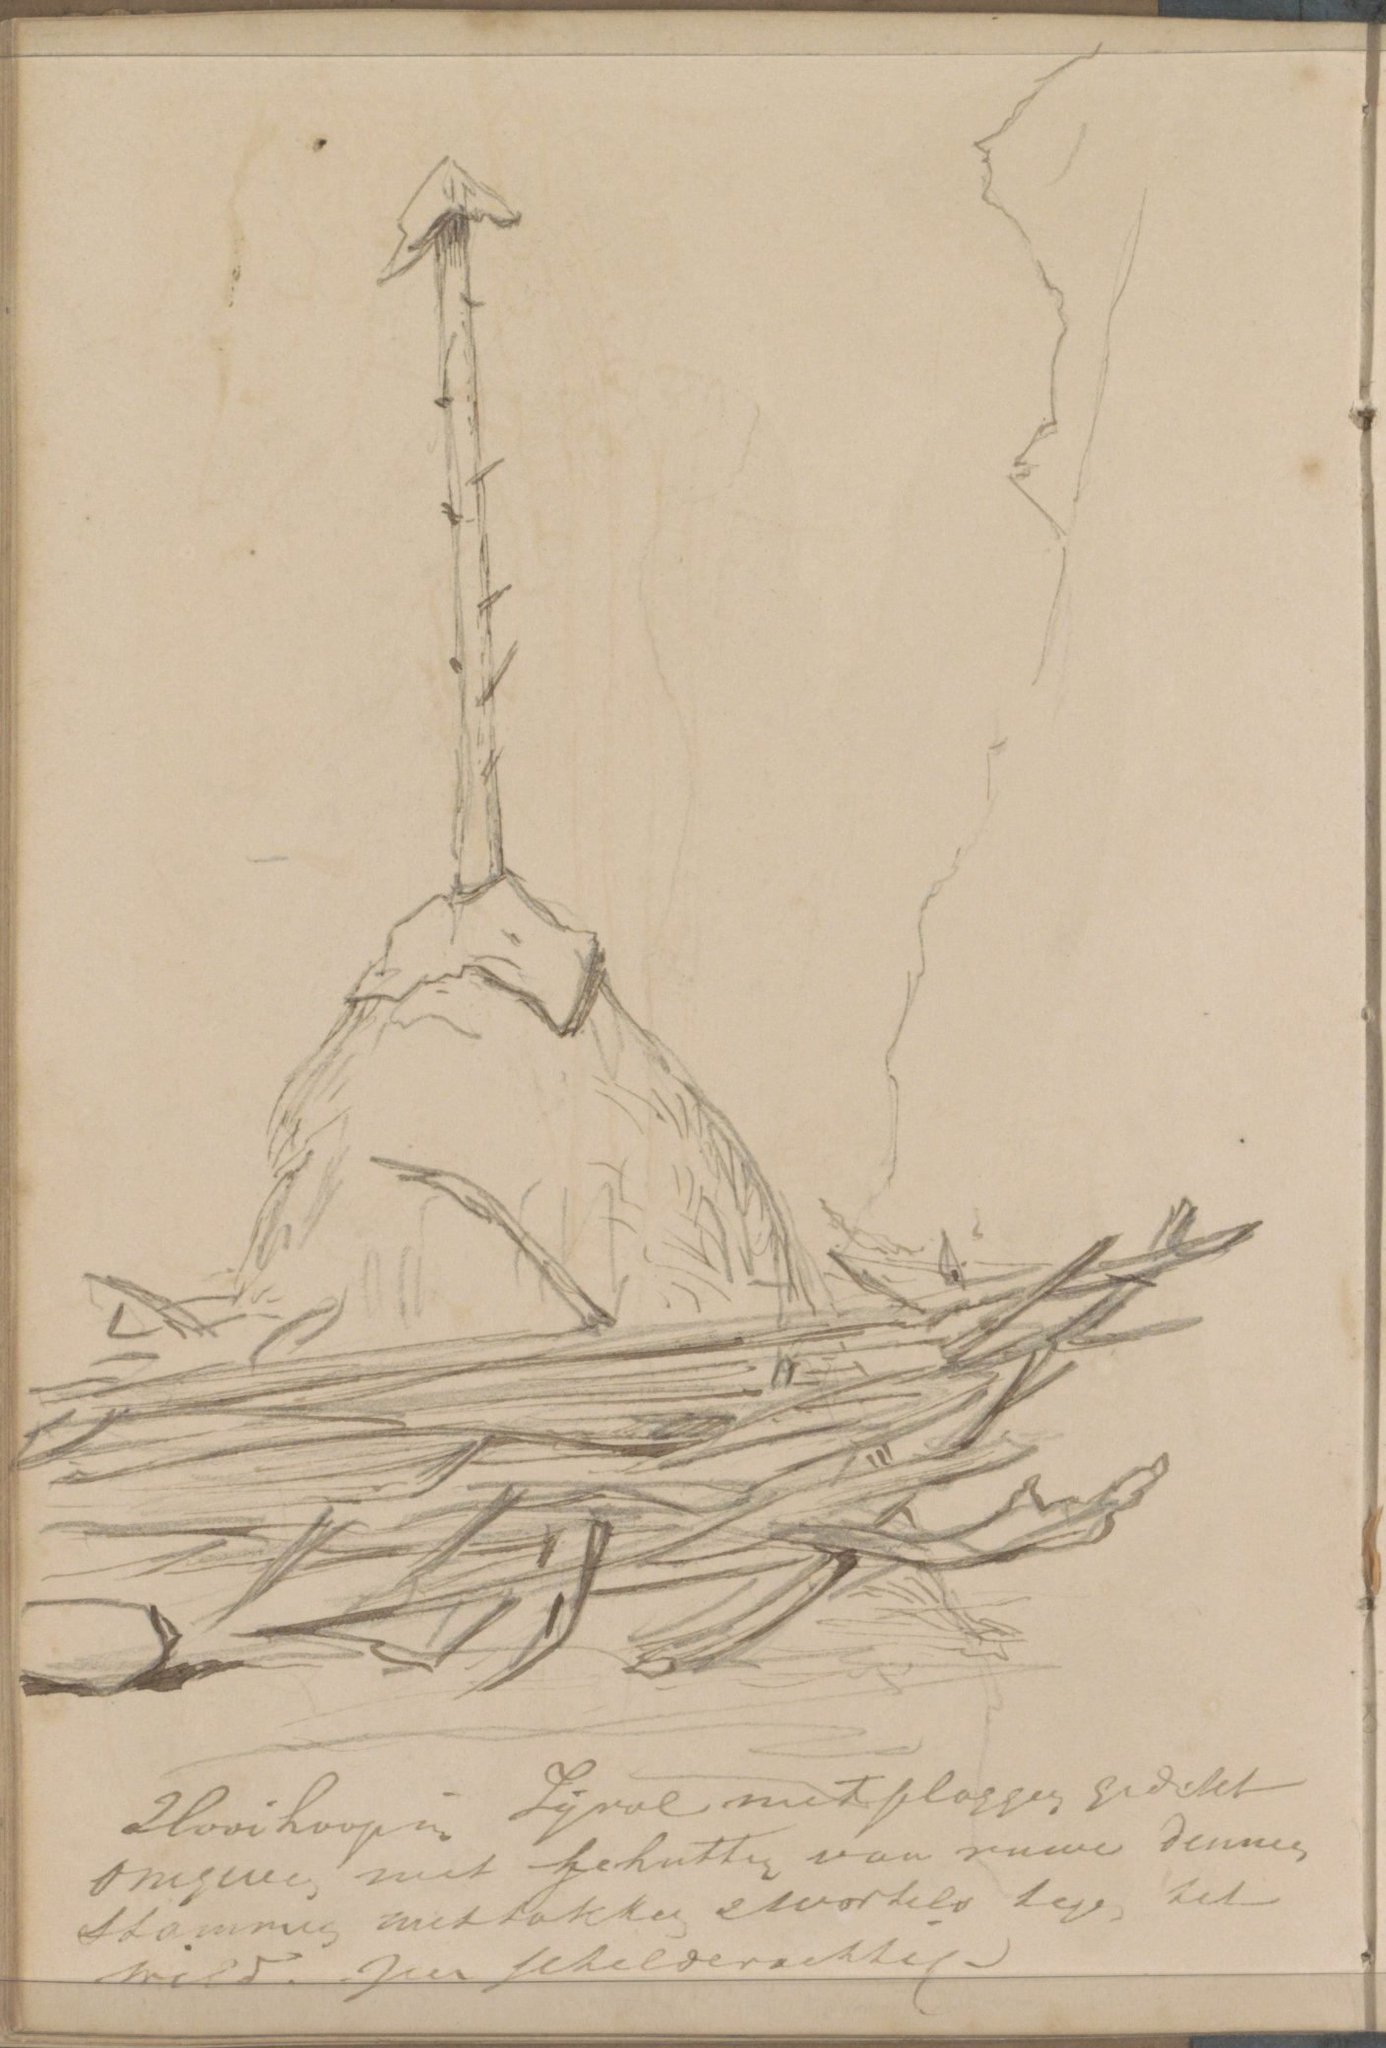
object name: sketchbook leaf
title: Hooiberg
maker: johannes tavenraat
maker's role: draughtsman, painter, print maker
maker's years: 1809-1881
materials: ink, paper, pencil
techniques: pen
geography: tirol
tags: hay-stack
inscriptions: annotation: ‘Hooihoop in Tijrol met plaggen gedikt/ omgeven met heihutten van ruwe dennen/ stammen met takken & wortels [...] het/ veld zeer schilderachtig.’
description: Rondom de hooiberg plaggen ter versterking. Blad 19 verso uit een schetsboek met 47 bladen.